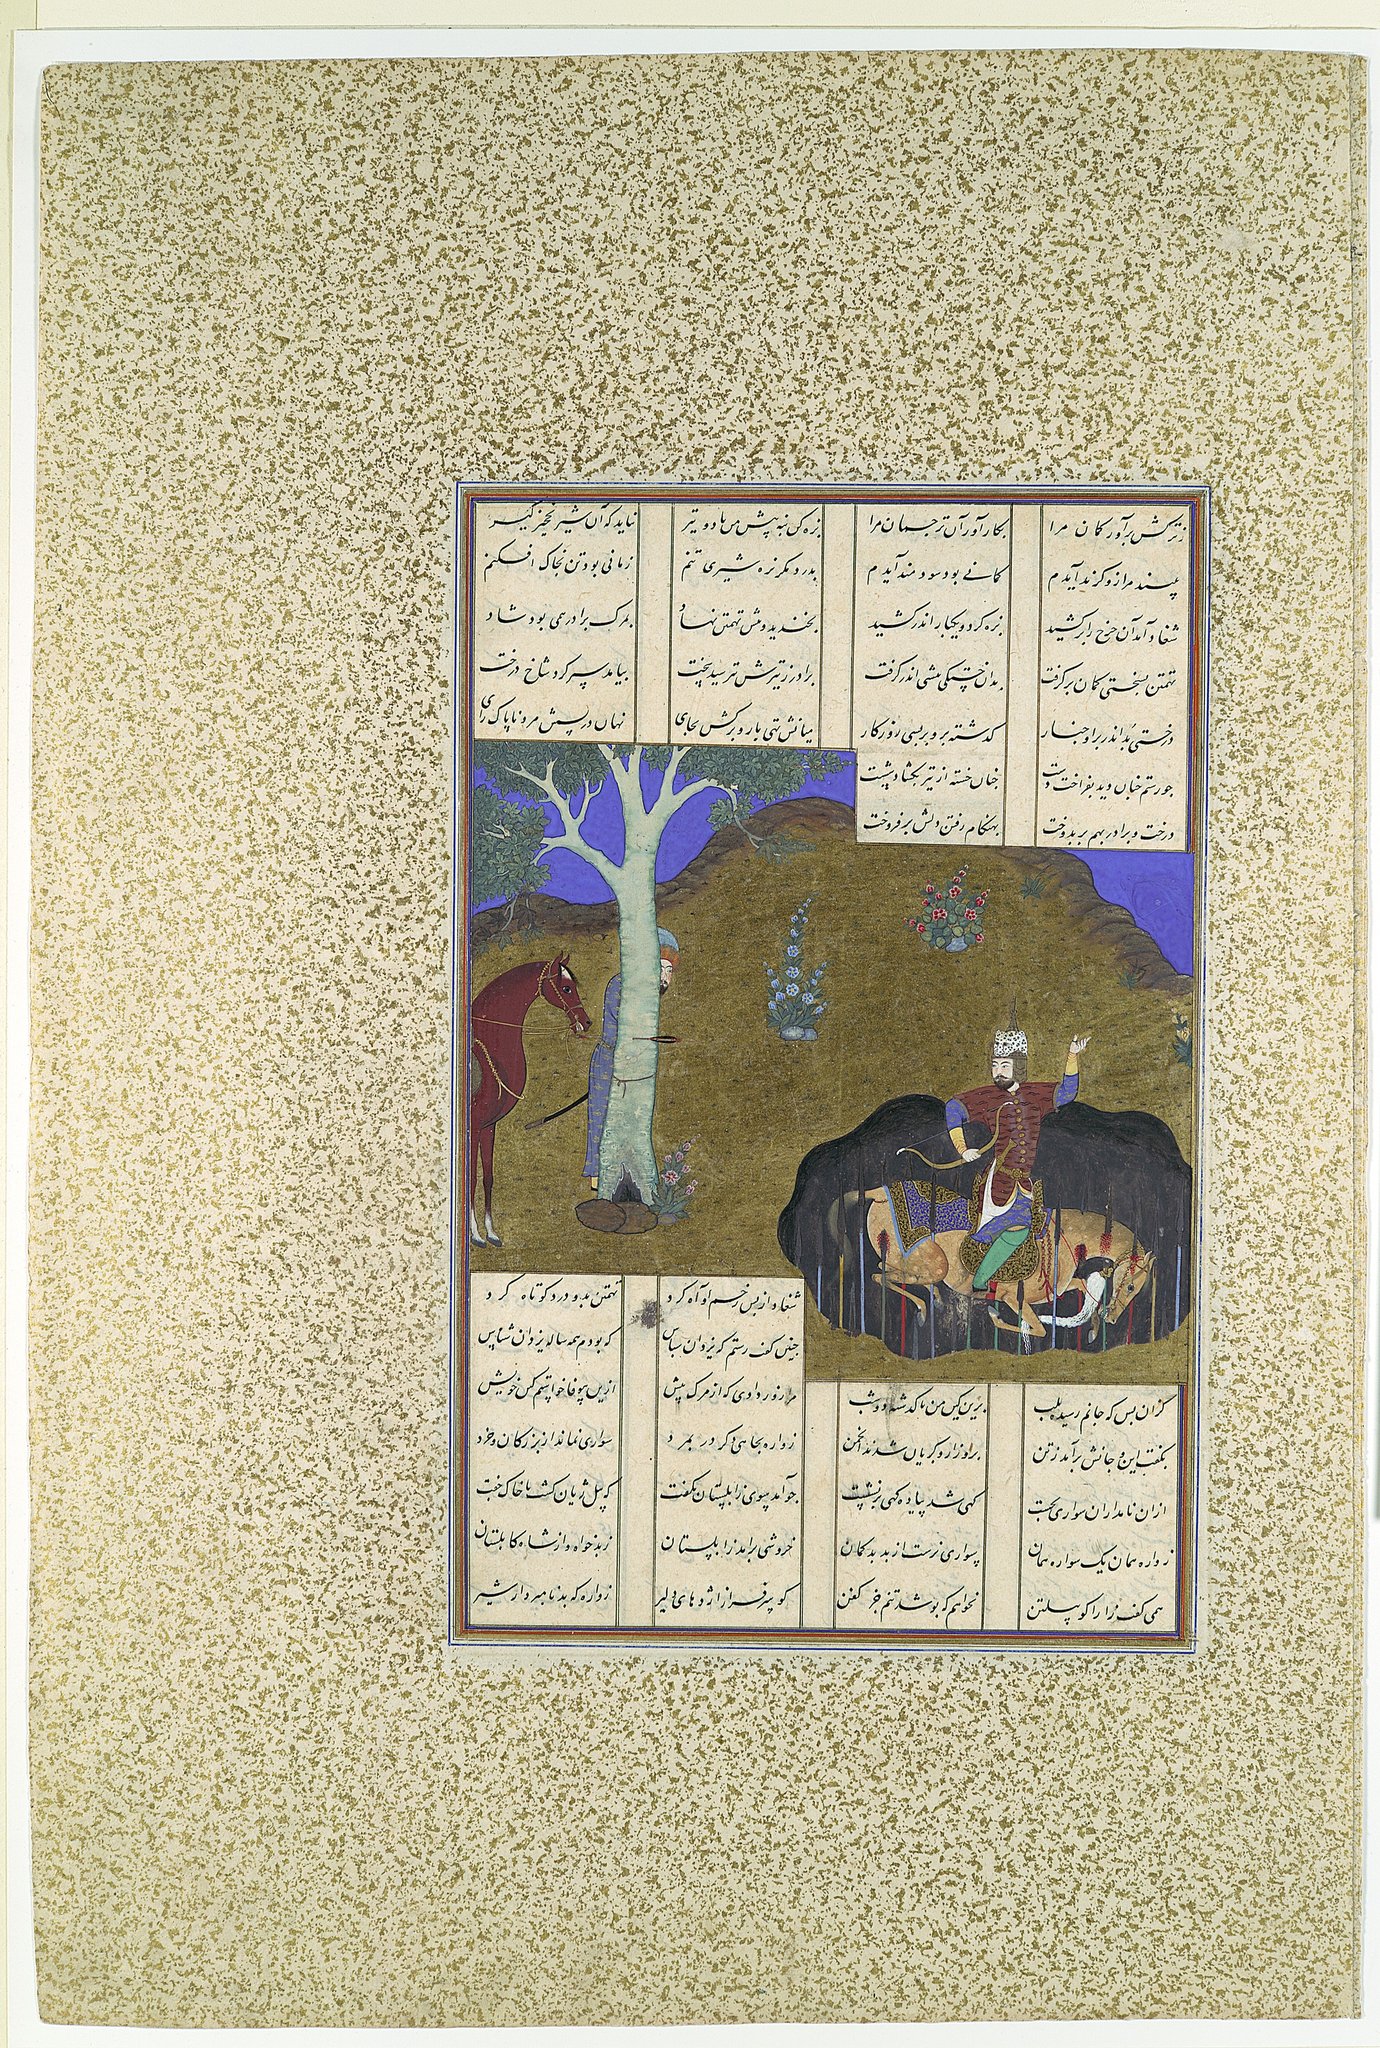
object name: folio from an illustrated manuscript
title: "Rustam Avenges His Own Impending Death", Folio 472r from the Shahnama (Book of Kings) of Shah Tahmasp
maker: abu'l qasim firdausi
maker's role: author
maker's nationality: iranian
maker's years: 935-1020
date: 1525-1530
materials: gold, ink, paper, silver, watercolor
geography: iran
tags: men,horses